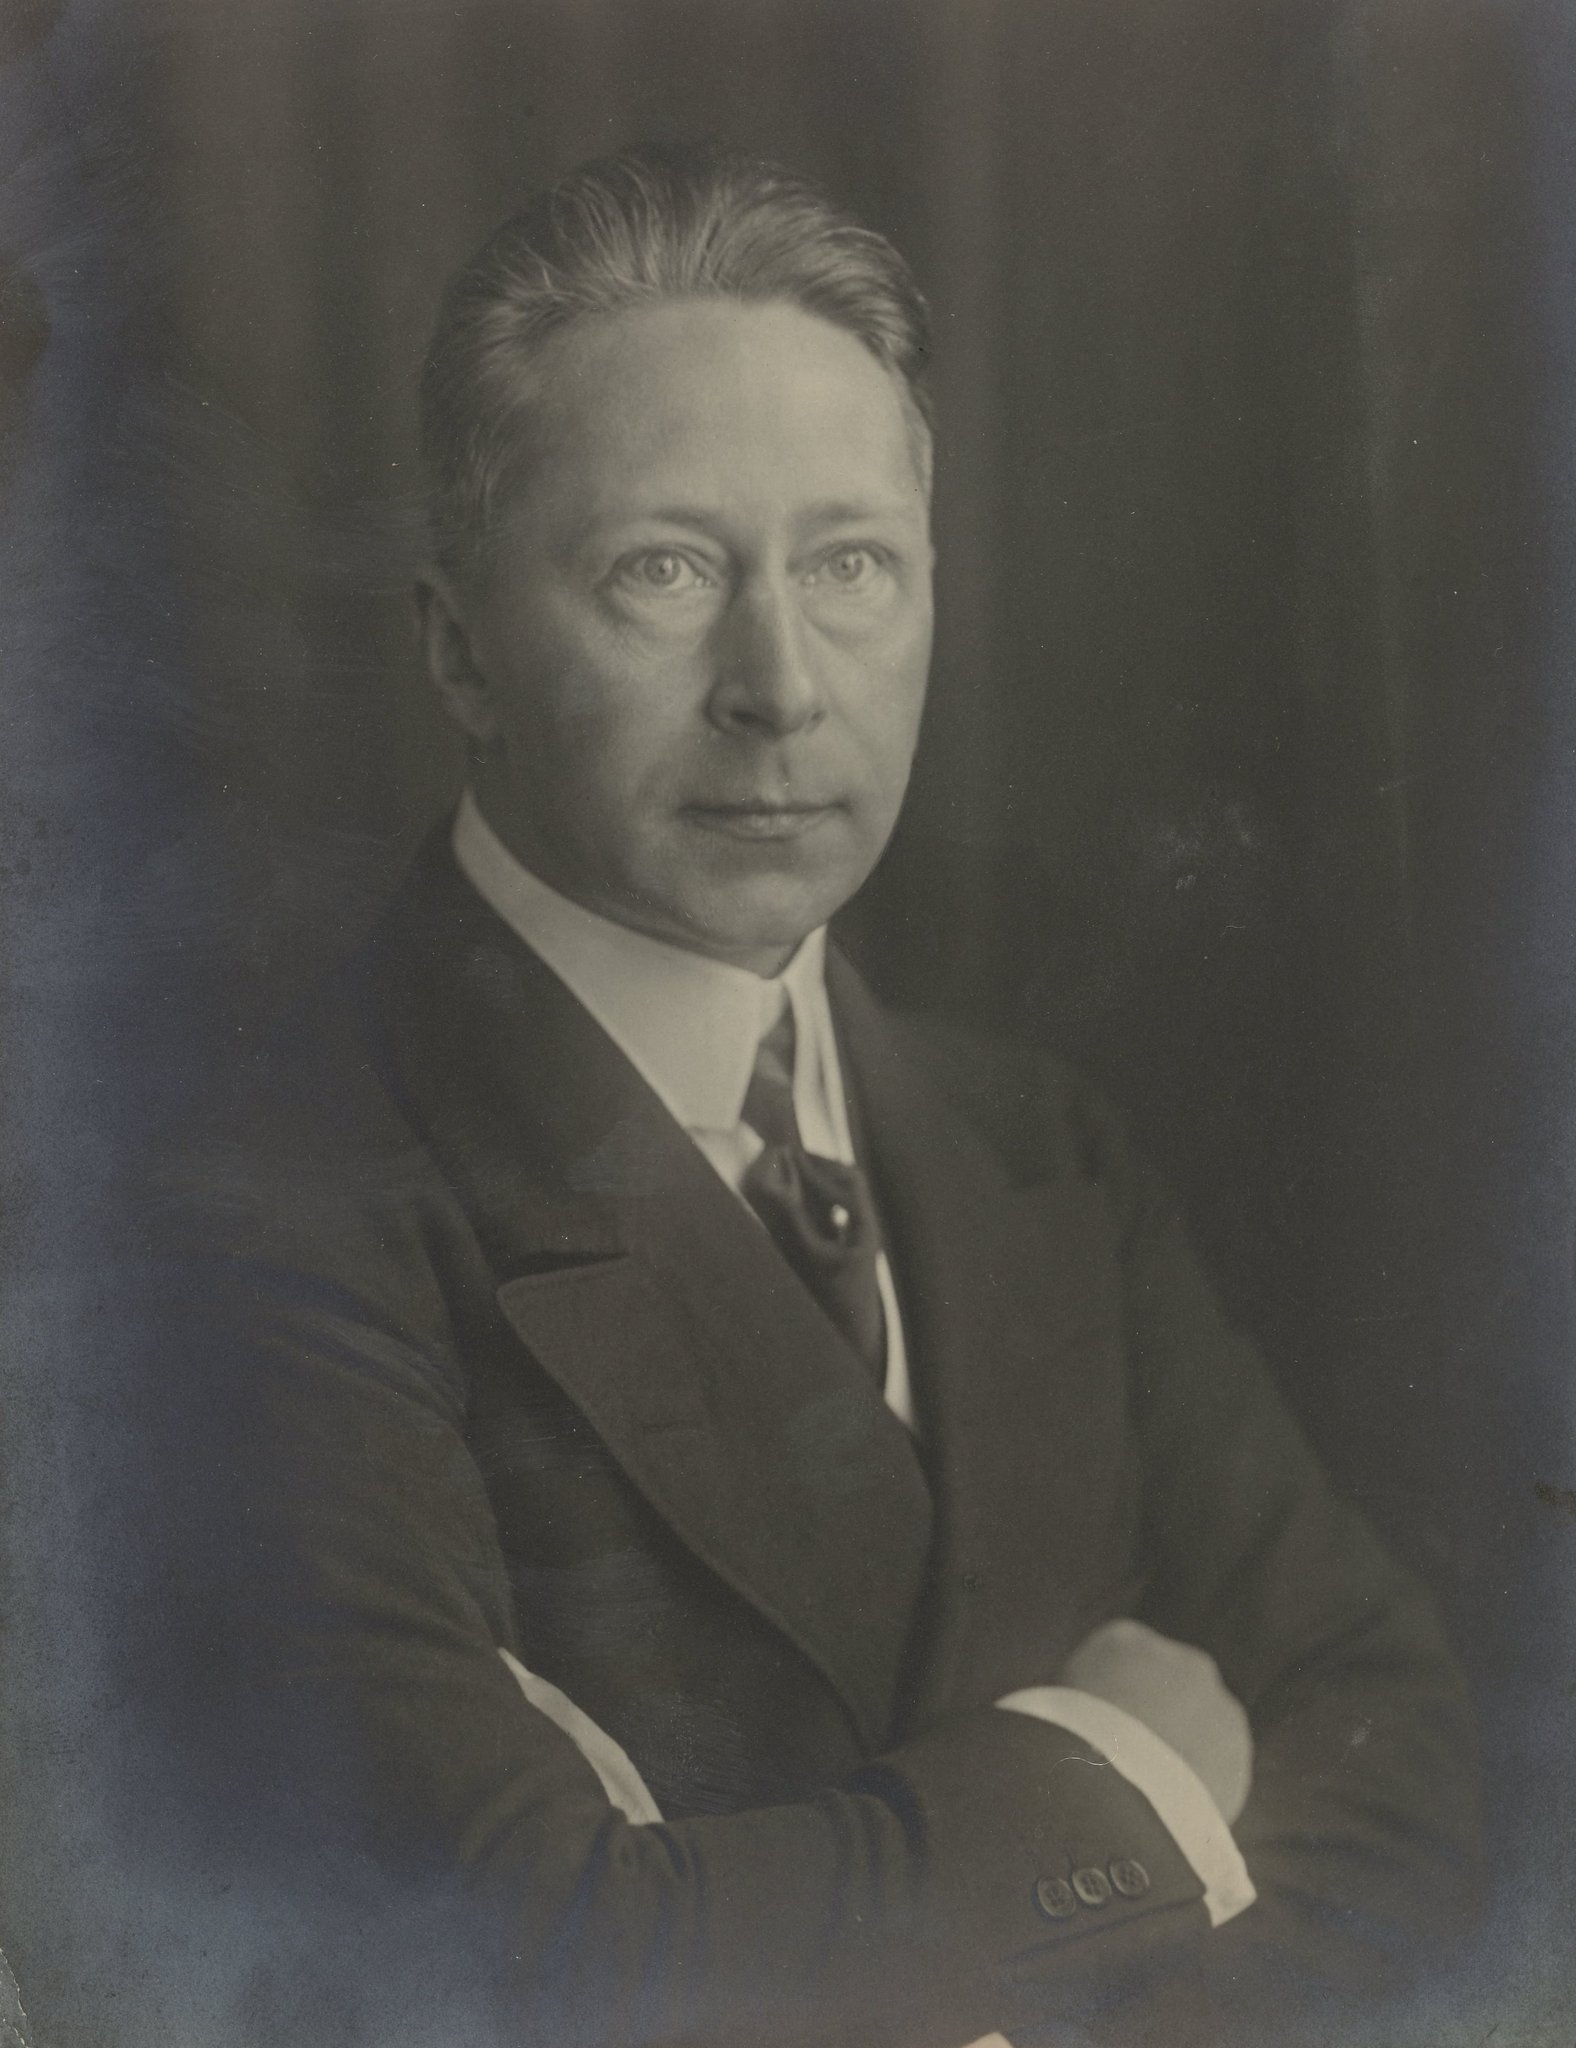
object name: photograph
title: Portret van de Duitse kroonprins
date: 1938-1948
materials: photographic support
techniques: photography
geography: amsterdam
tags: the hague, print maker, wilhelmina of the netherlands, wilhelm ii (keizer van duitsland)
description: Drie kleine en drie grote afdrukken van een manlijk lid van de Duitse Hohenzollern familie. Mogelijk familie van de laatste Duitse keizer.